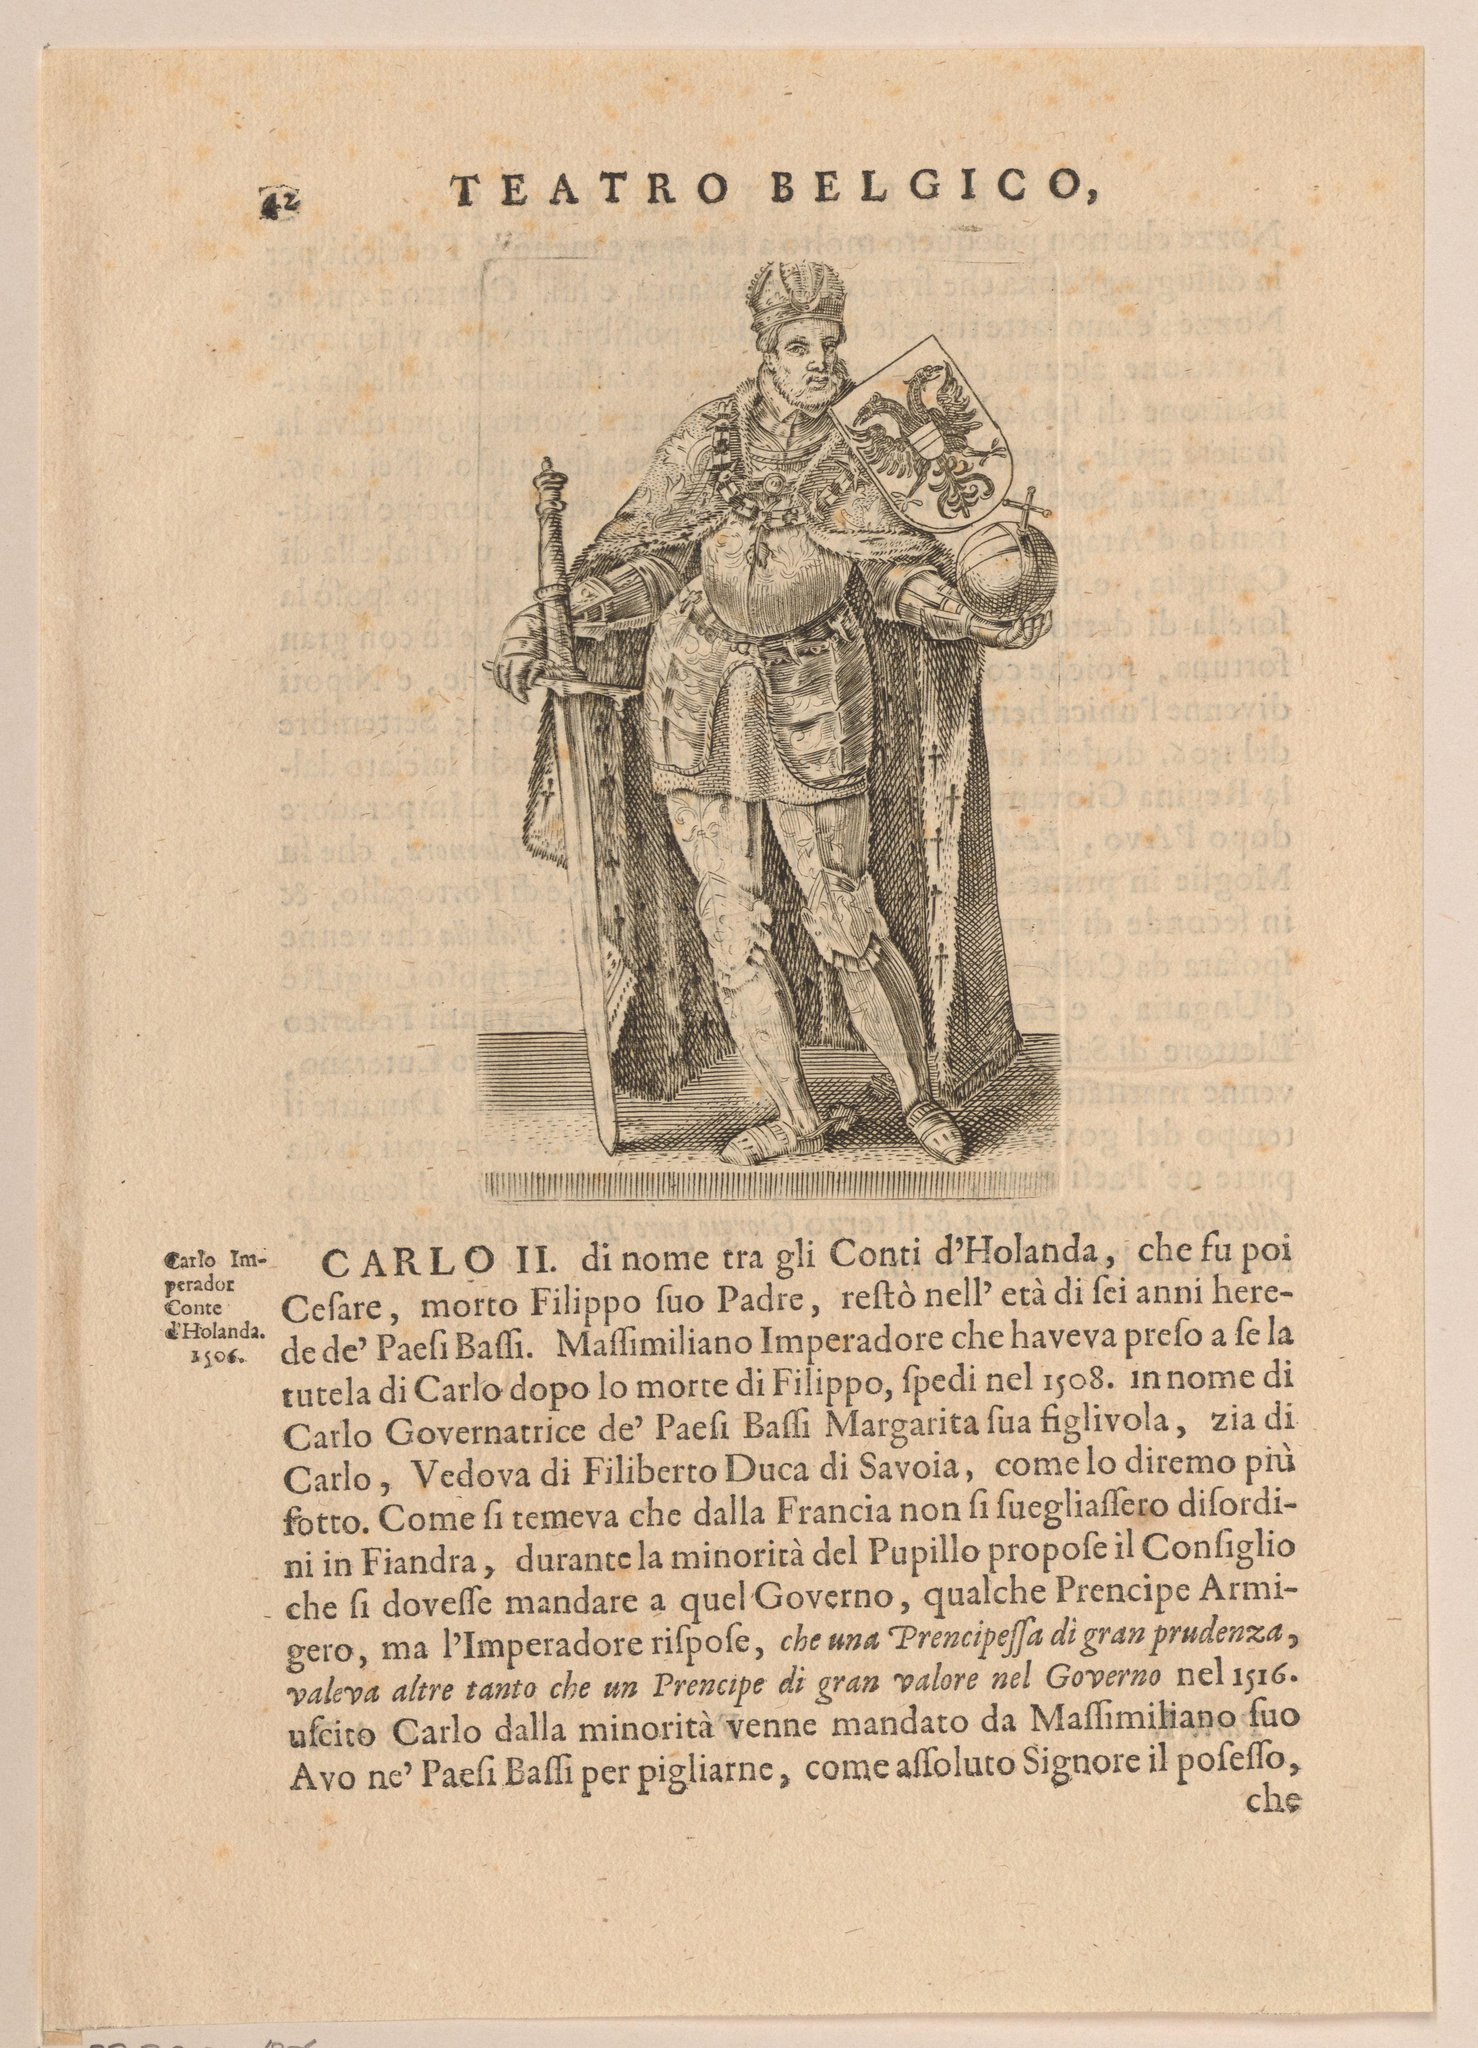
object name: print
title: Portret van keizer Karel V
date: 1690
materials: paper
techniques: engraving, letterpress printing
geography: amsterdam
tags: ghent, charles v (holy roman emperor and king of spain), double-headed eagle, crown (symbol of sovereignty), orb (symbol of sovereignty; sphere with cross on top), historical persons, knighthood order of the golden fleece, king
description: Prent uit: Leti, Gregorio. Teatro Belgico, o vero ritratti historici (...). Amsterdam: Willem de Jonge, 1690, dl. 1, p. 42.